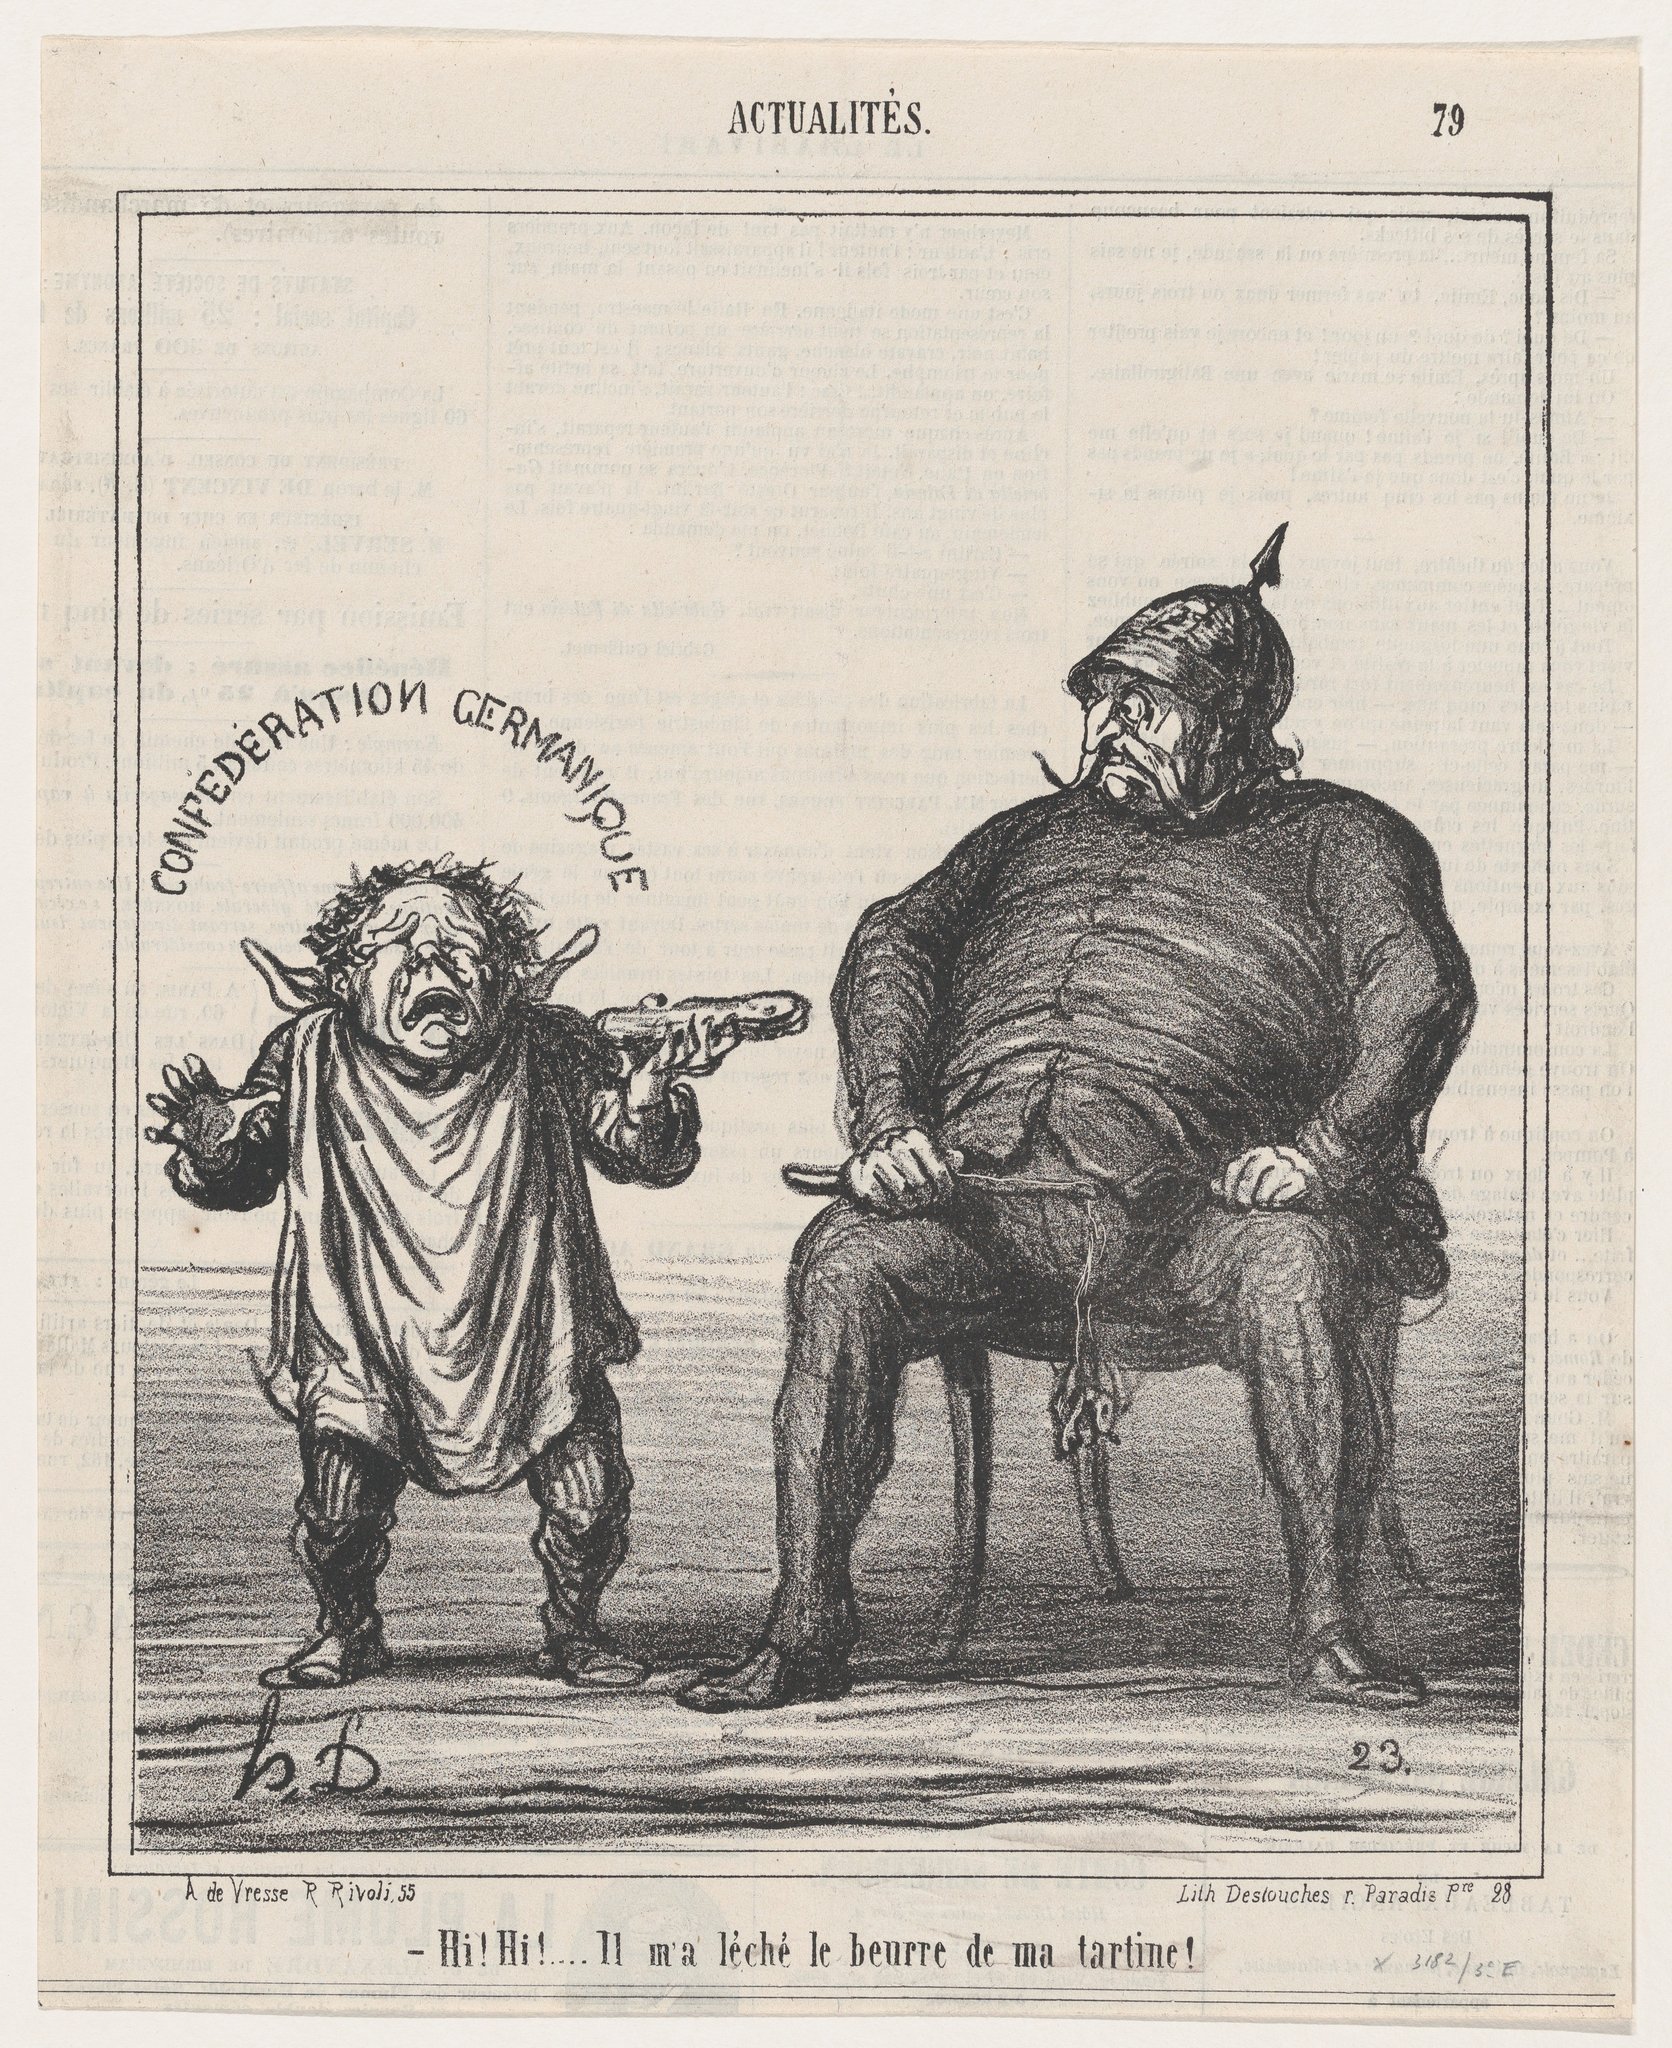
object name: print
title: Hi! Hi! he licked the butter off my bread!, from 'News of the day,' published in "Le Charivari"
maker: honoré daumier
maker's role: artist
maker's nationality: french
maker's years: 1808-1879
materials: paper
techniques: lithograph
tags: satire,men